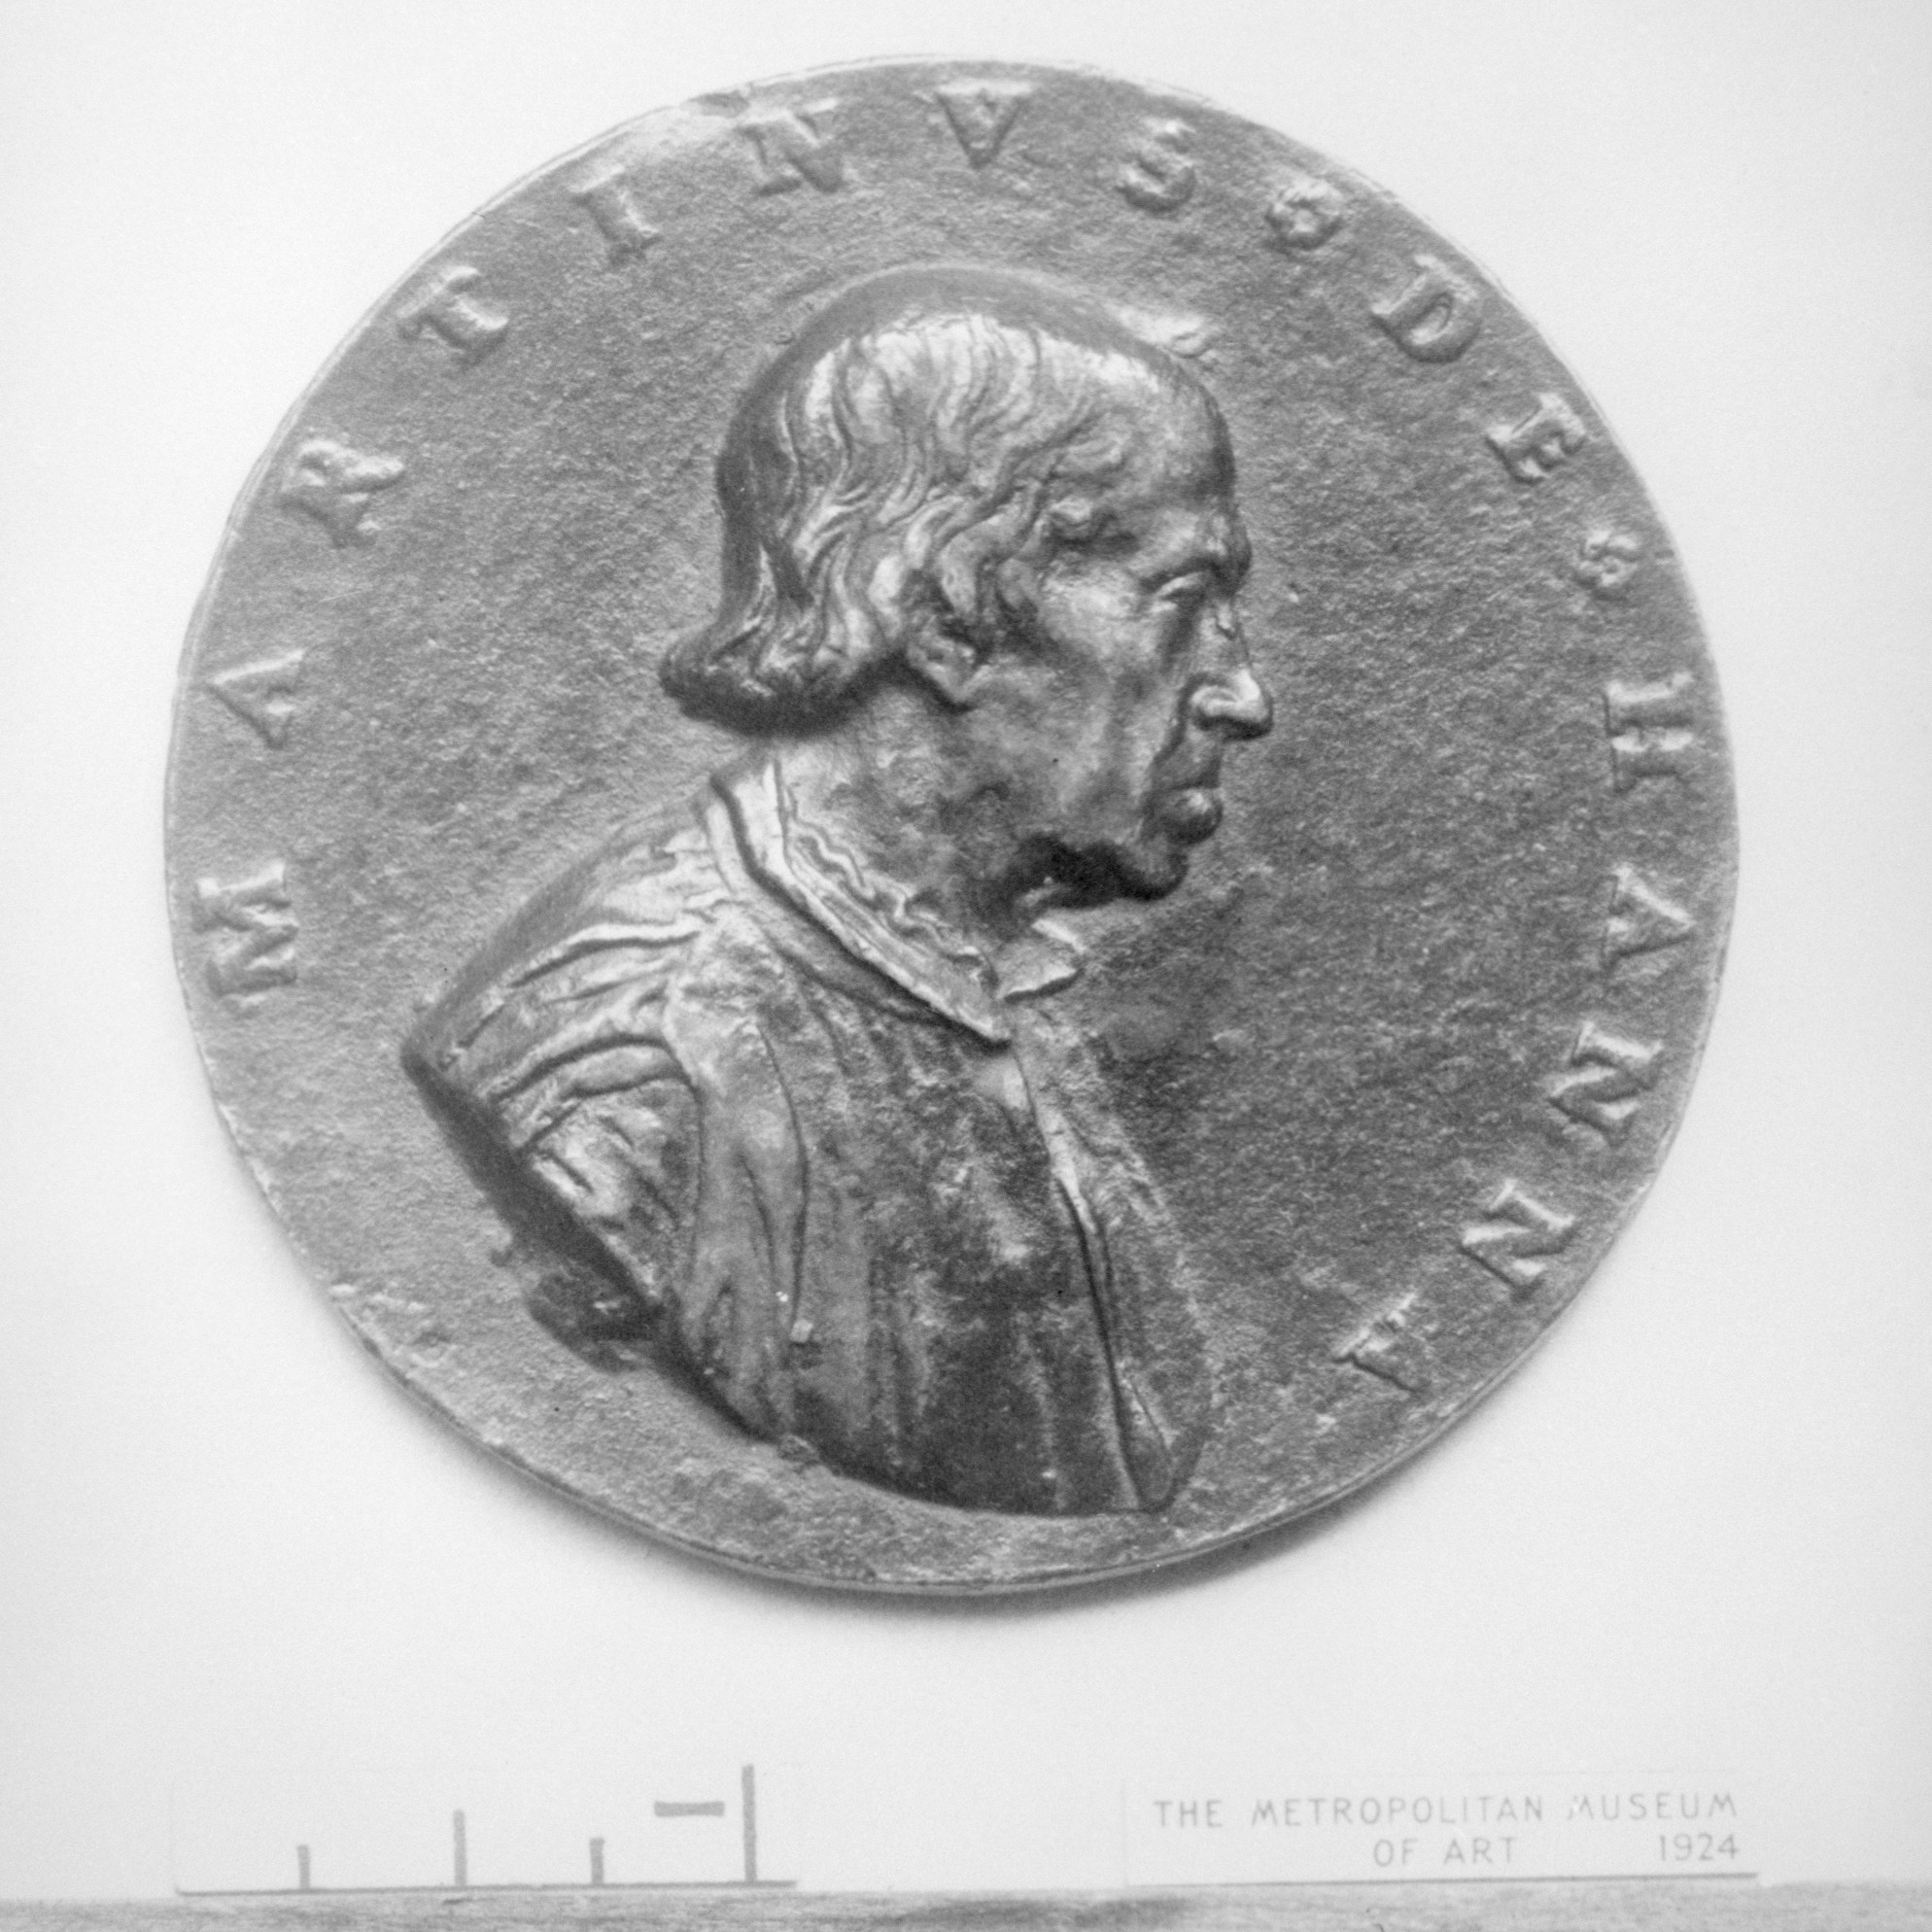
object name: medal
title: Martinus de Hanna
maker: leone leoni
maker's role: artist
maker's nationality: italian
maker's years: 1504-1590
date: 1525-1550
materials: bronze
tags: men,profiles